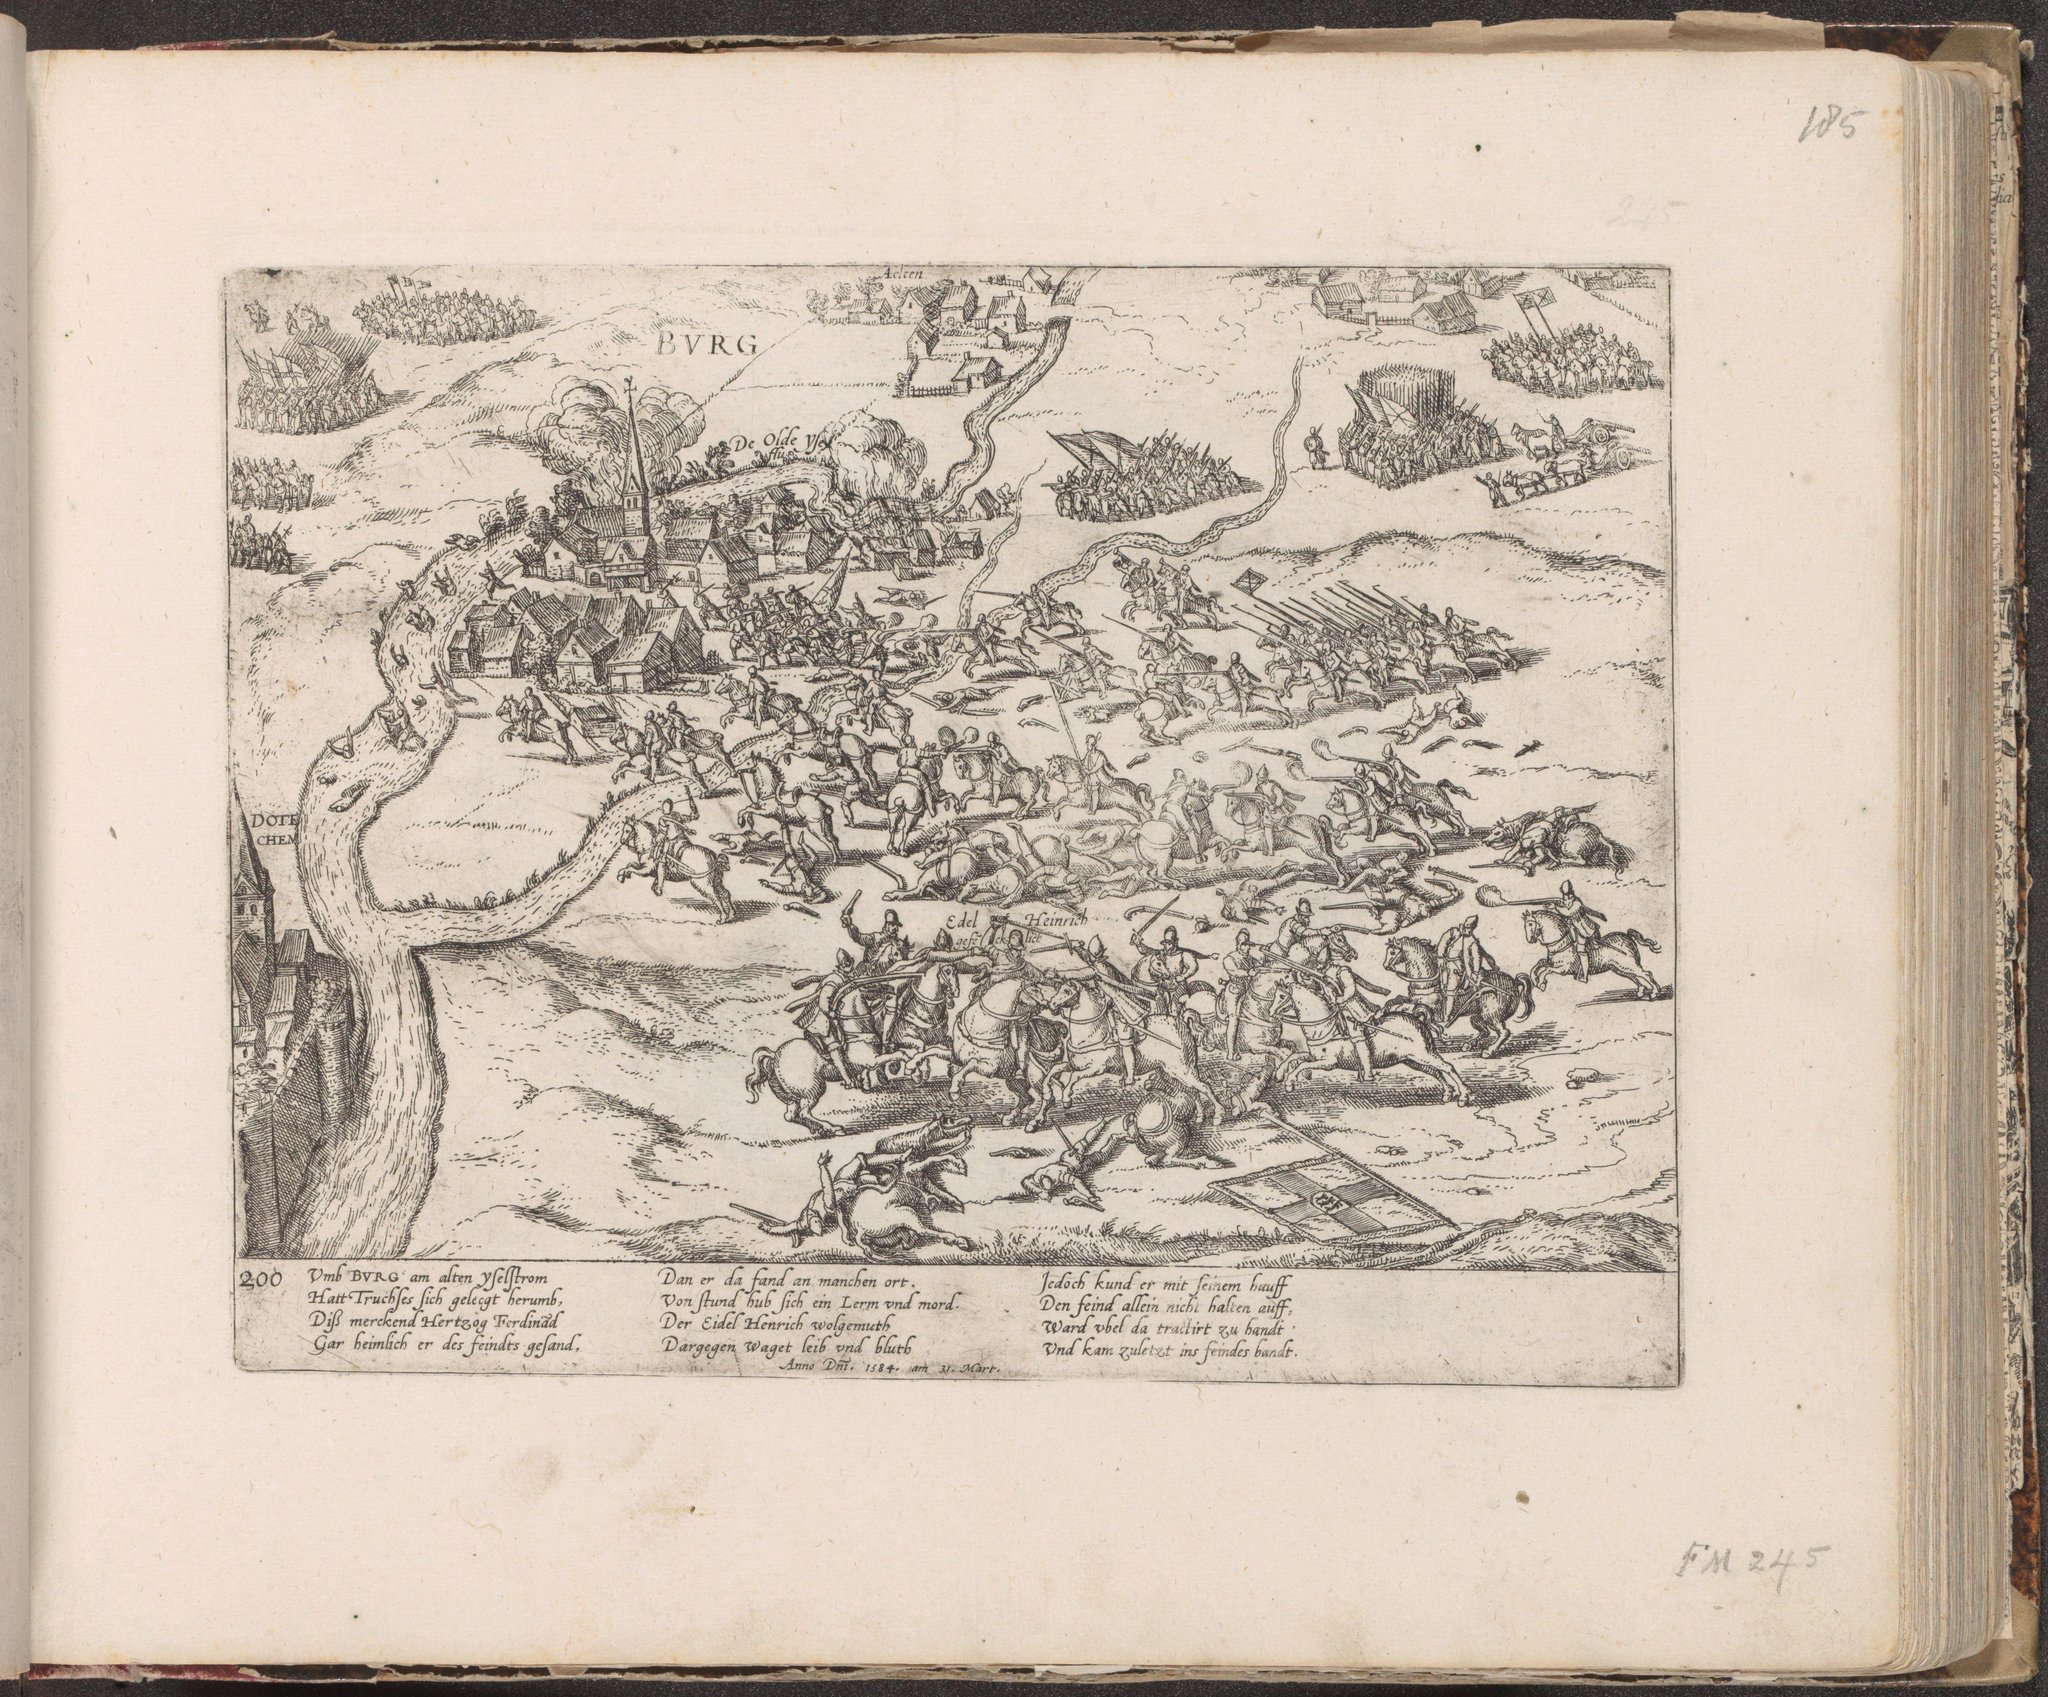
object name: print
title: Beleg van Burg, 1584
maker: frans hogenberg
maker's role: print maker, publisher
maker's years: 1538-1590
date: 1587-1591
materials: paper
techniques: etching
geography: cologne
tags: siege, position war, battle (+ land forces)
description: Beleg van Burg (Terborg) aan de IJssel bij Doetinchem, 31 maart 1584. Veldslag tussen ruiters, links Doetinchem en de IJssel. Episode uit de Keulse Oorlog. Met onderschrift van 12 regels in het Duits. Linksonder genummerd: 200. De prent maakt deel uit van een album.